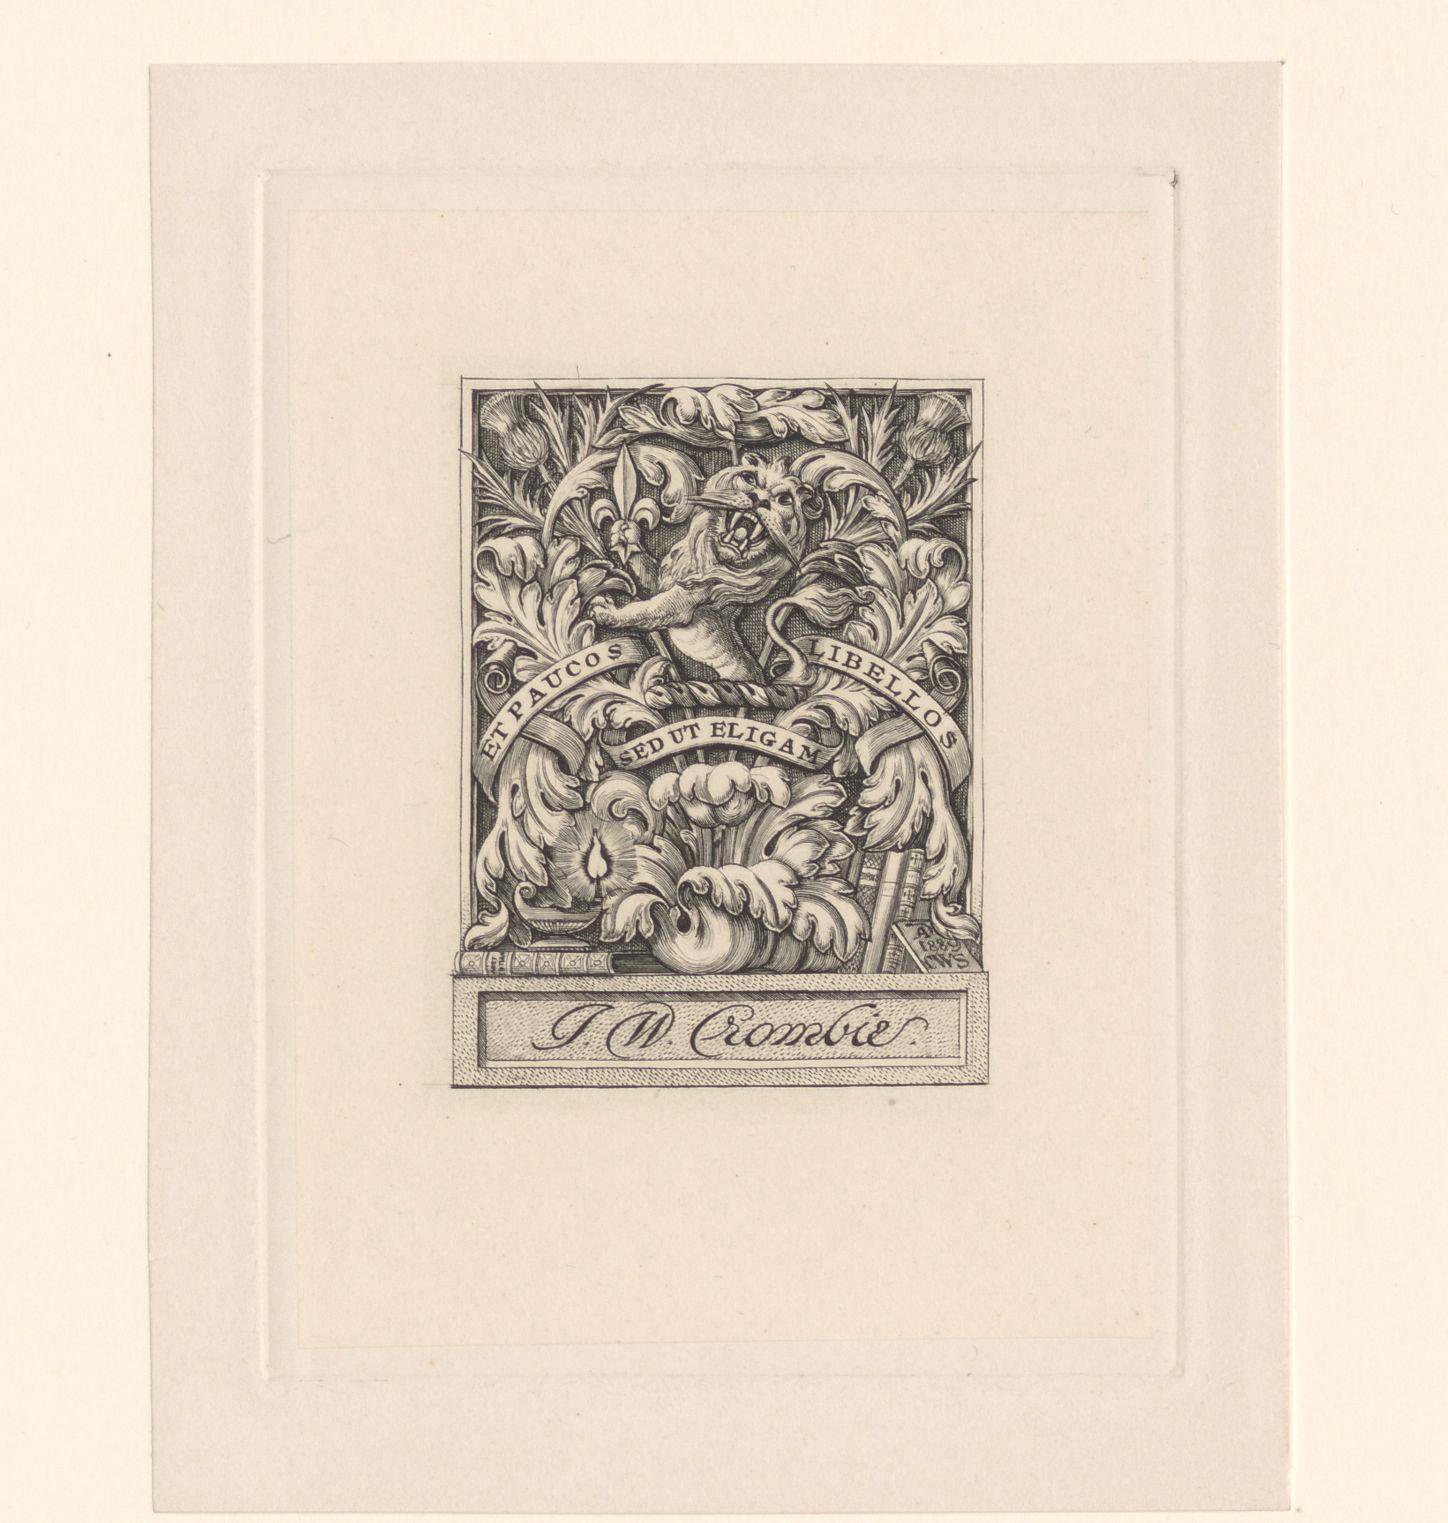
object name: bookplate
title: Ex libris van John William Crombie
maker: charles william sherborn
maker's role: print maker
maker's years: 1831-1912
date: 1889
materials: paper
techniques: engraving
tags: politician, foliage ~ ornament, book, beasts of prey, predatory animals: lion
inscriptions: collector's mark: Lugt 2228